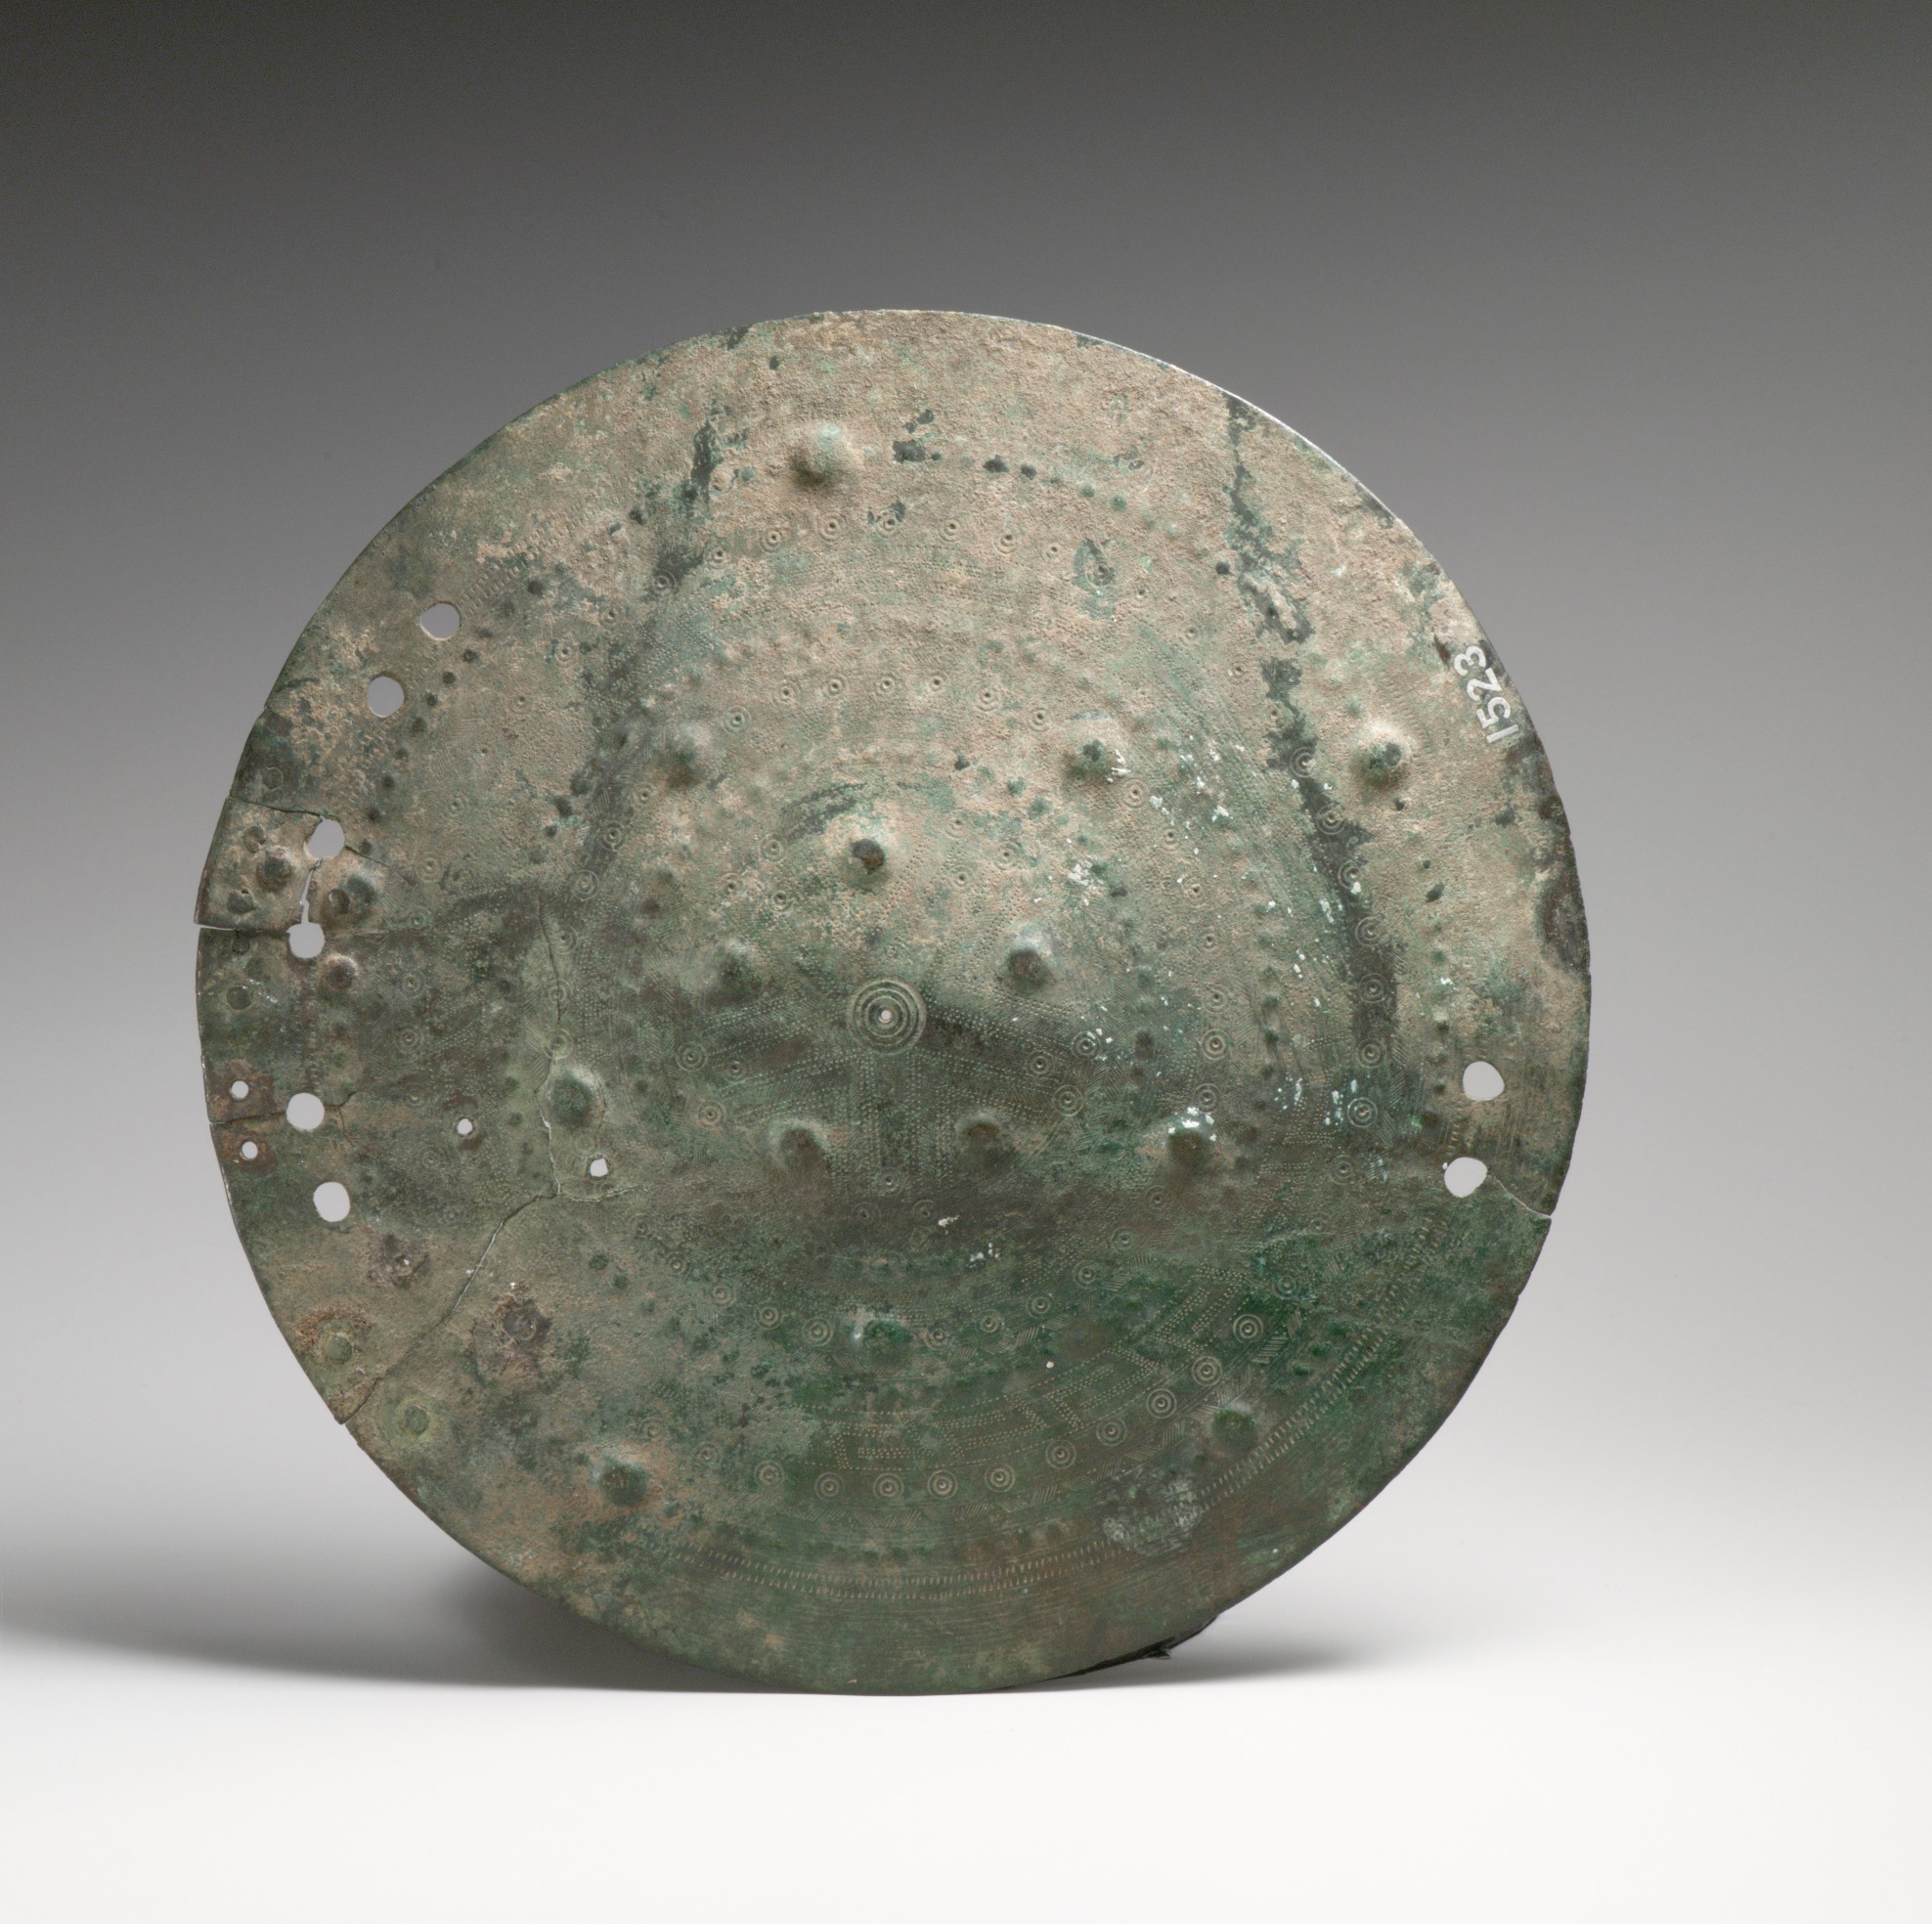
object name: disk, a shield bos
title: Bronze shield boss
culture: etruscan or italic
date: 700-601 BCE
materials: bronze